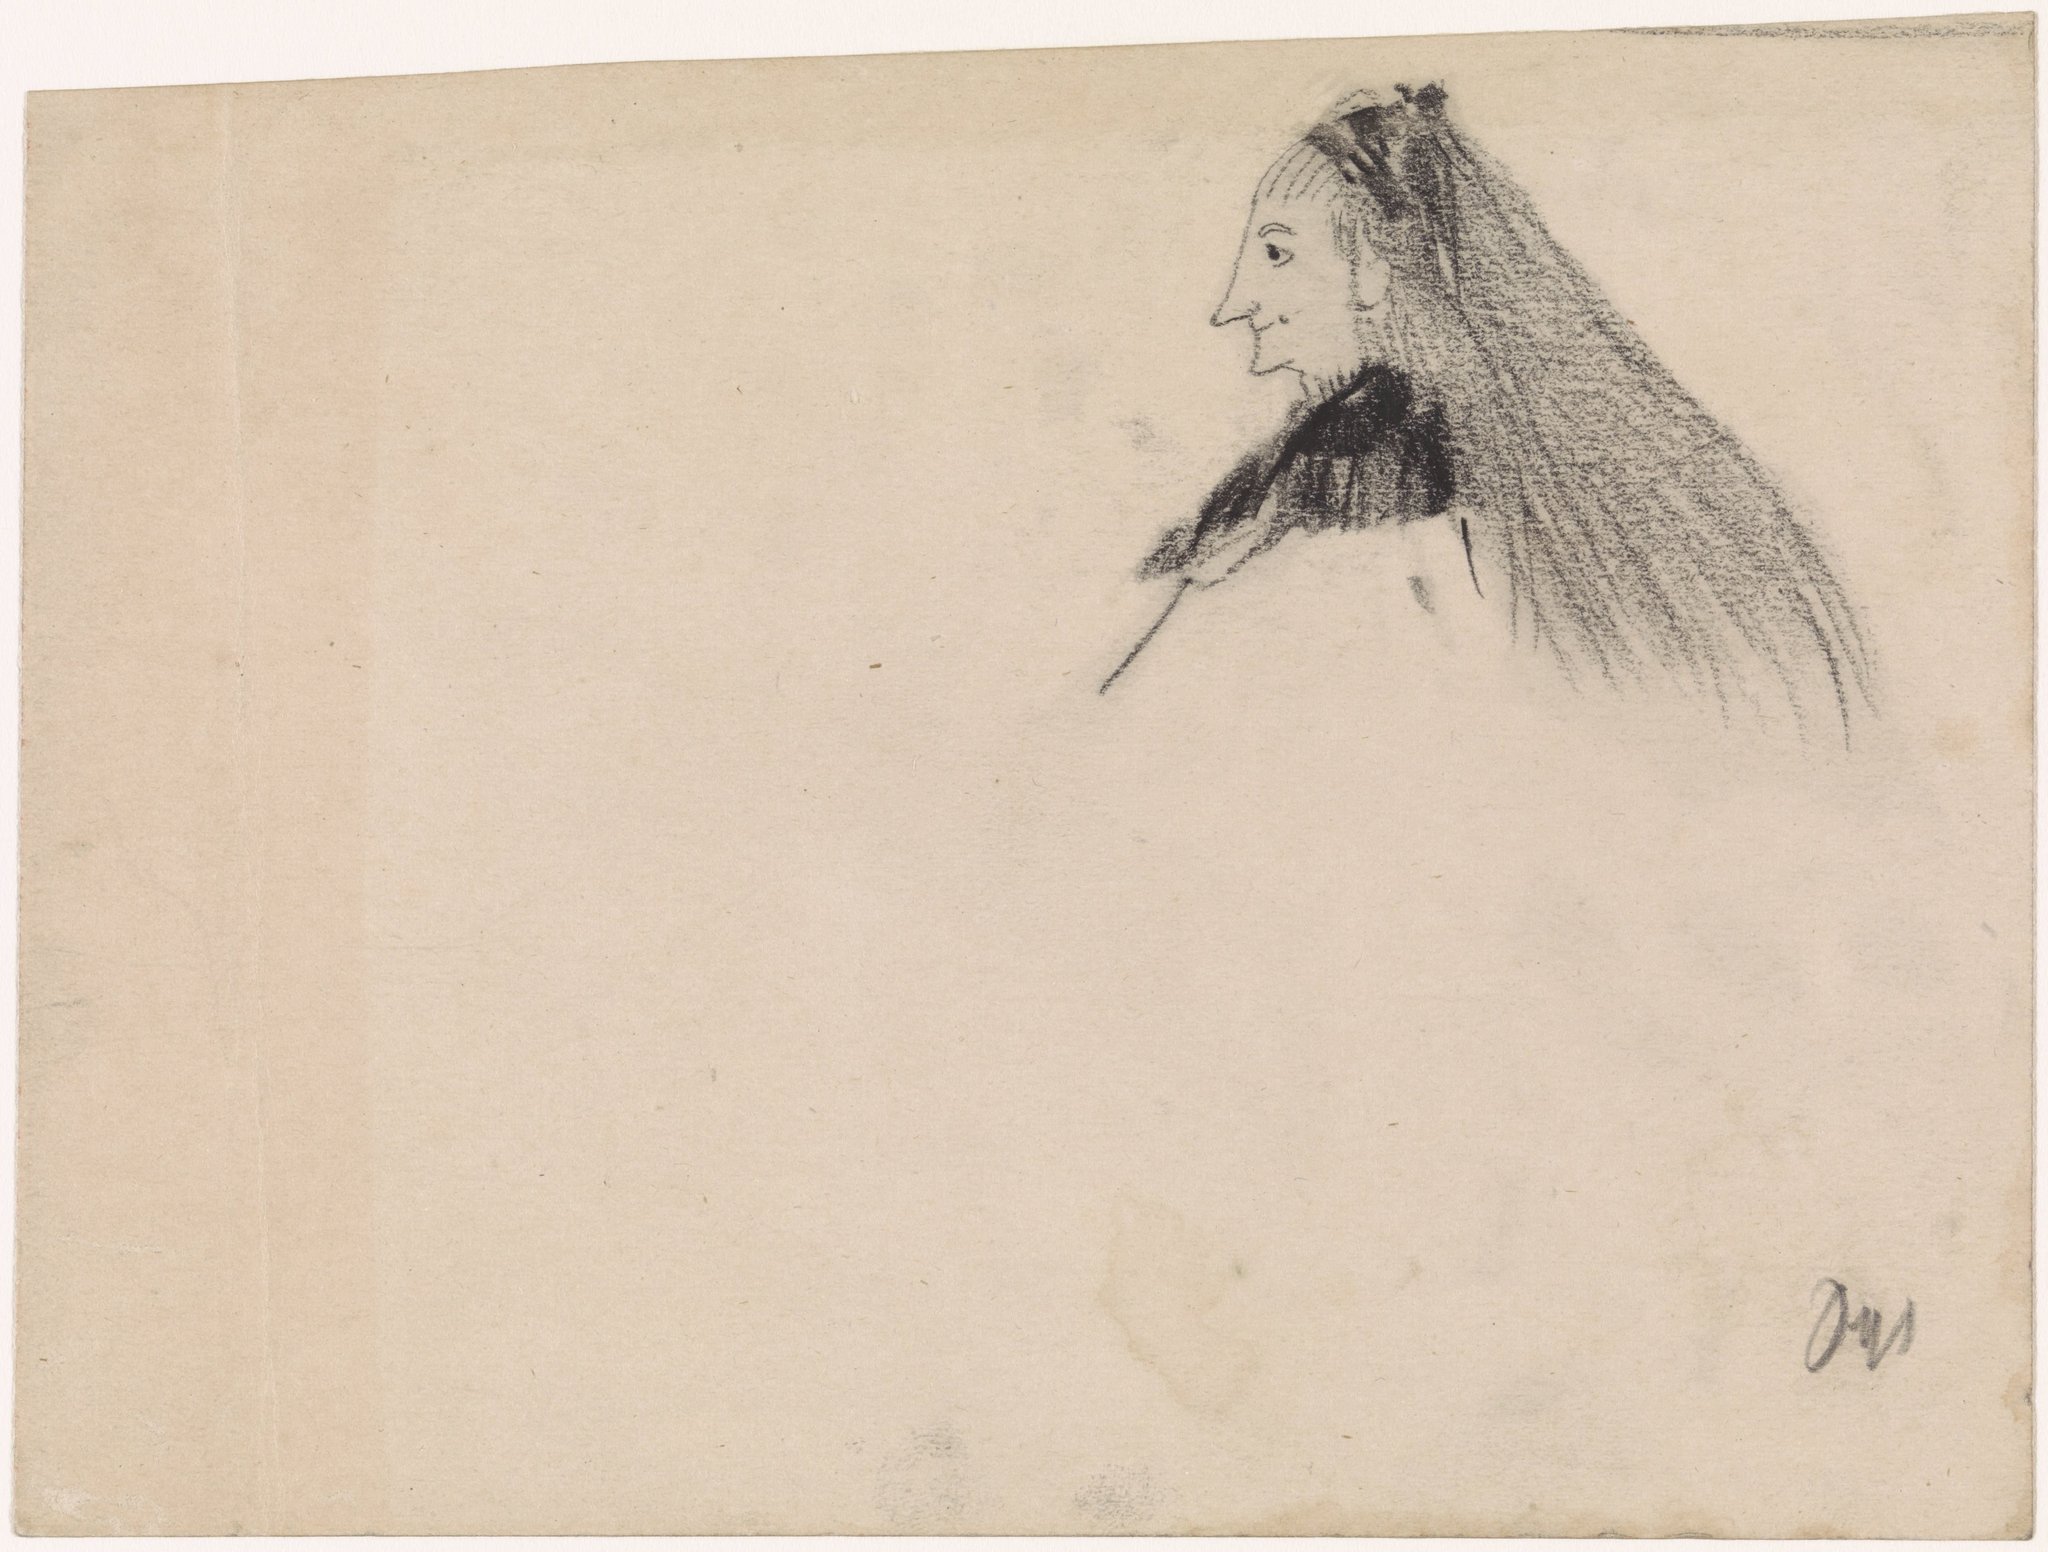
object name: drawing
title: Vrouw met lang haar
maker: gerrit willem dijsselhof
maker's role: designer, draughtsman, print maker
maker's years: 1866-1924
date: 1876-1924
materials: chalk, paper